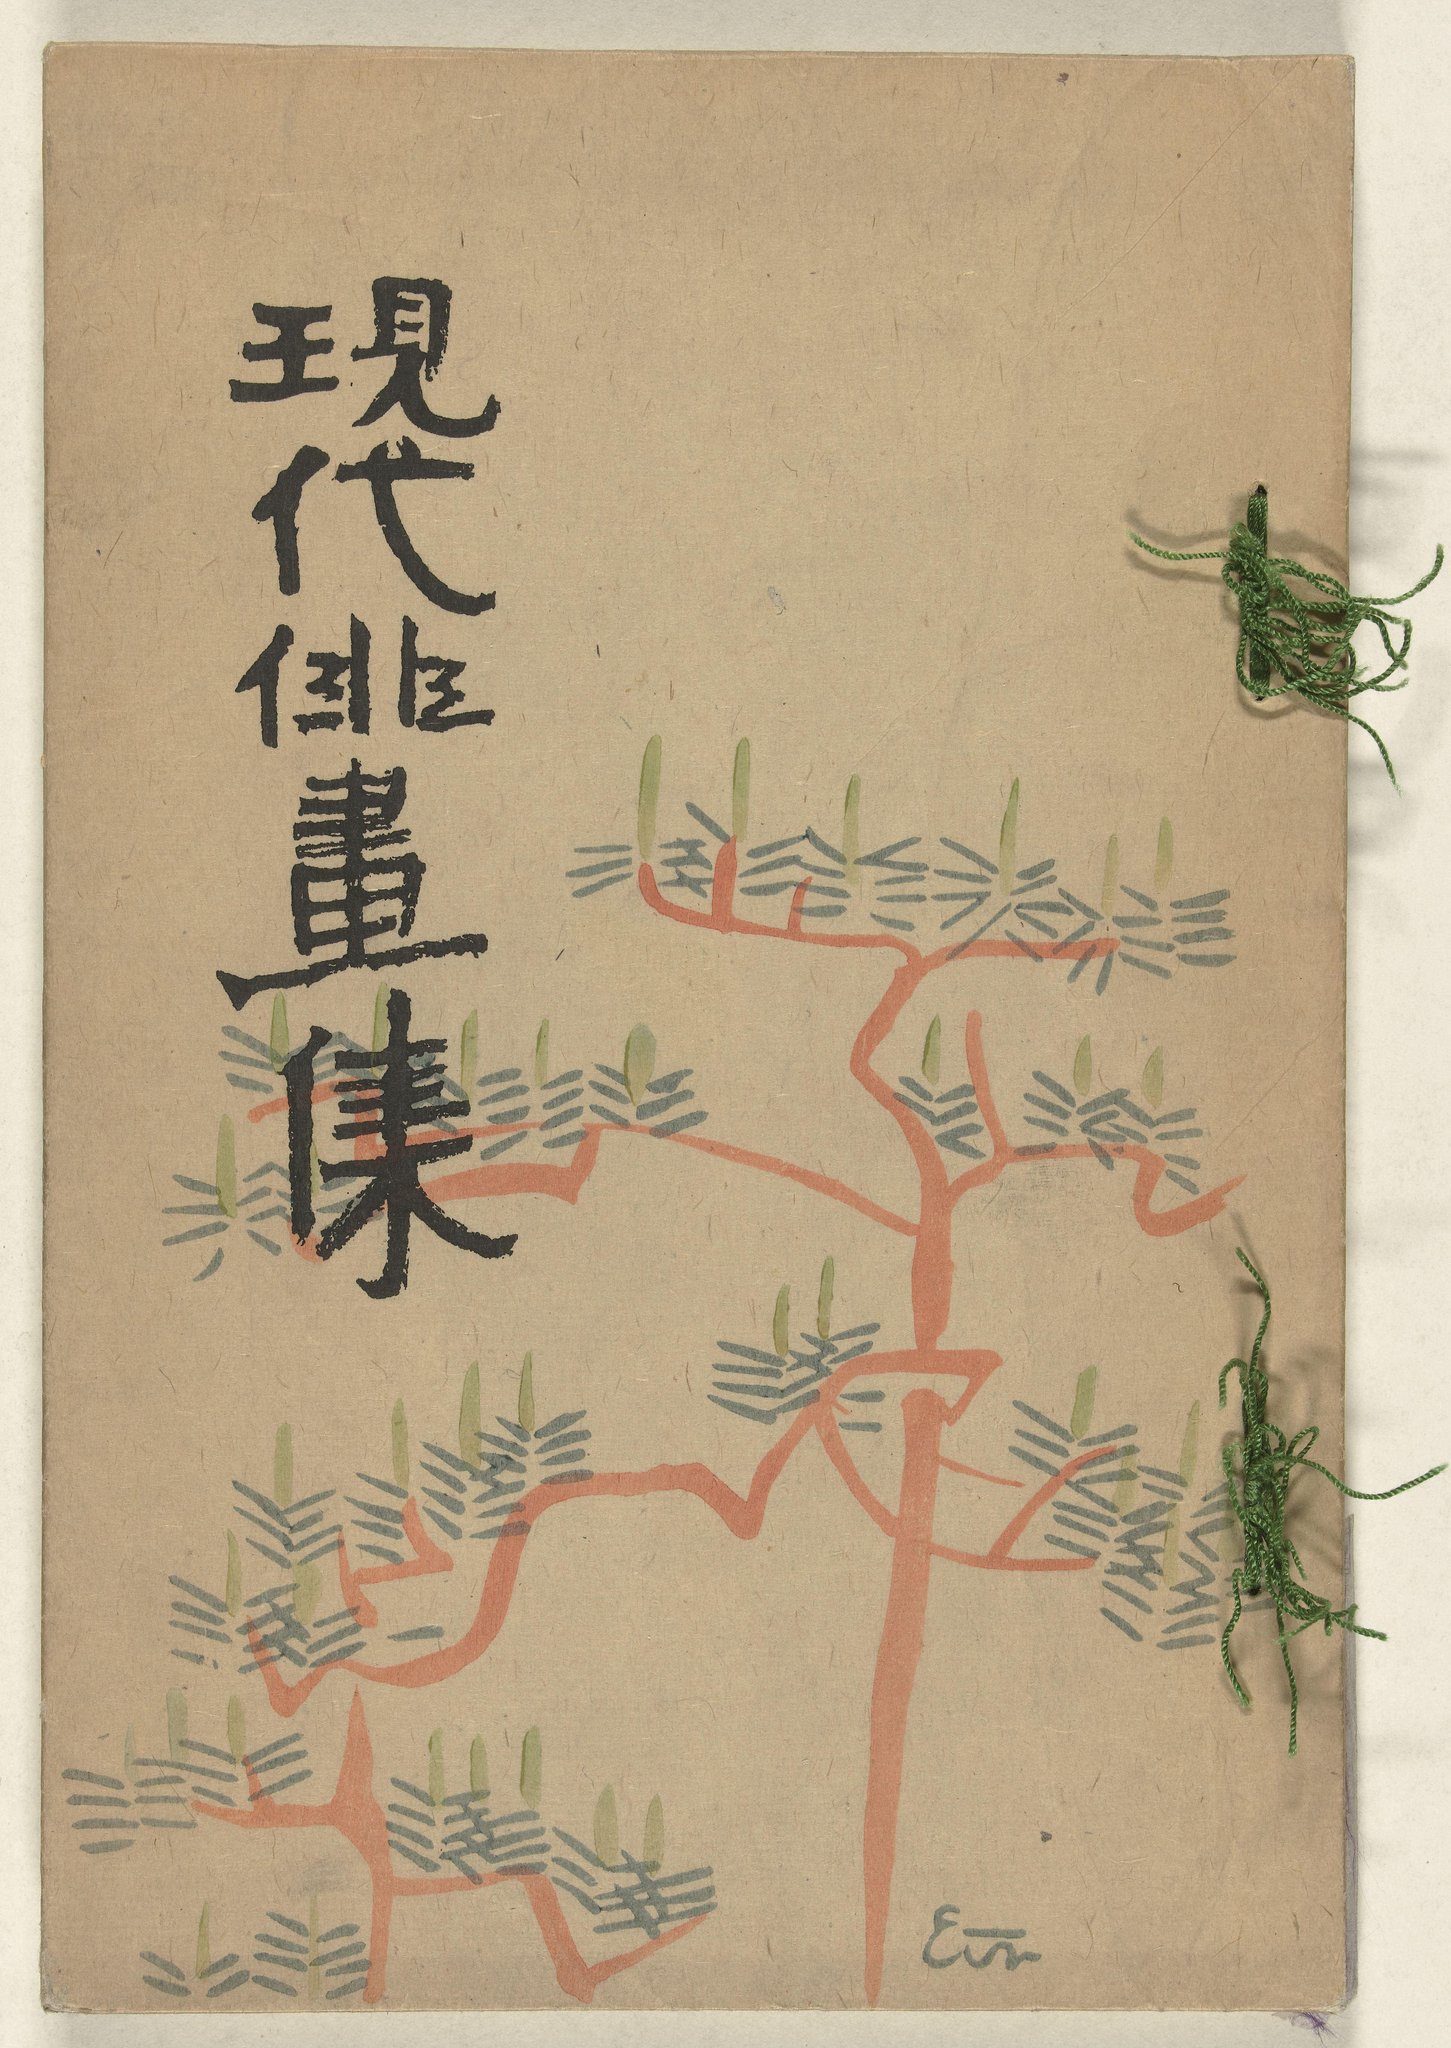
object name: book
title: Verzameling moderne snelle tekeningen - Zomer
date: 1907-1916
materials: paper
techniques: woodcut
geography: tokyo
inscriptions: date